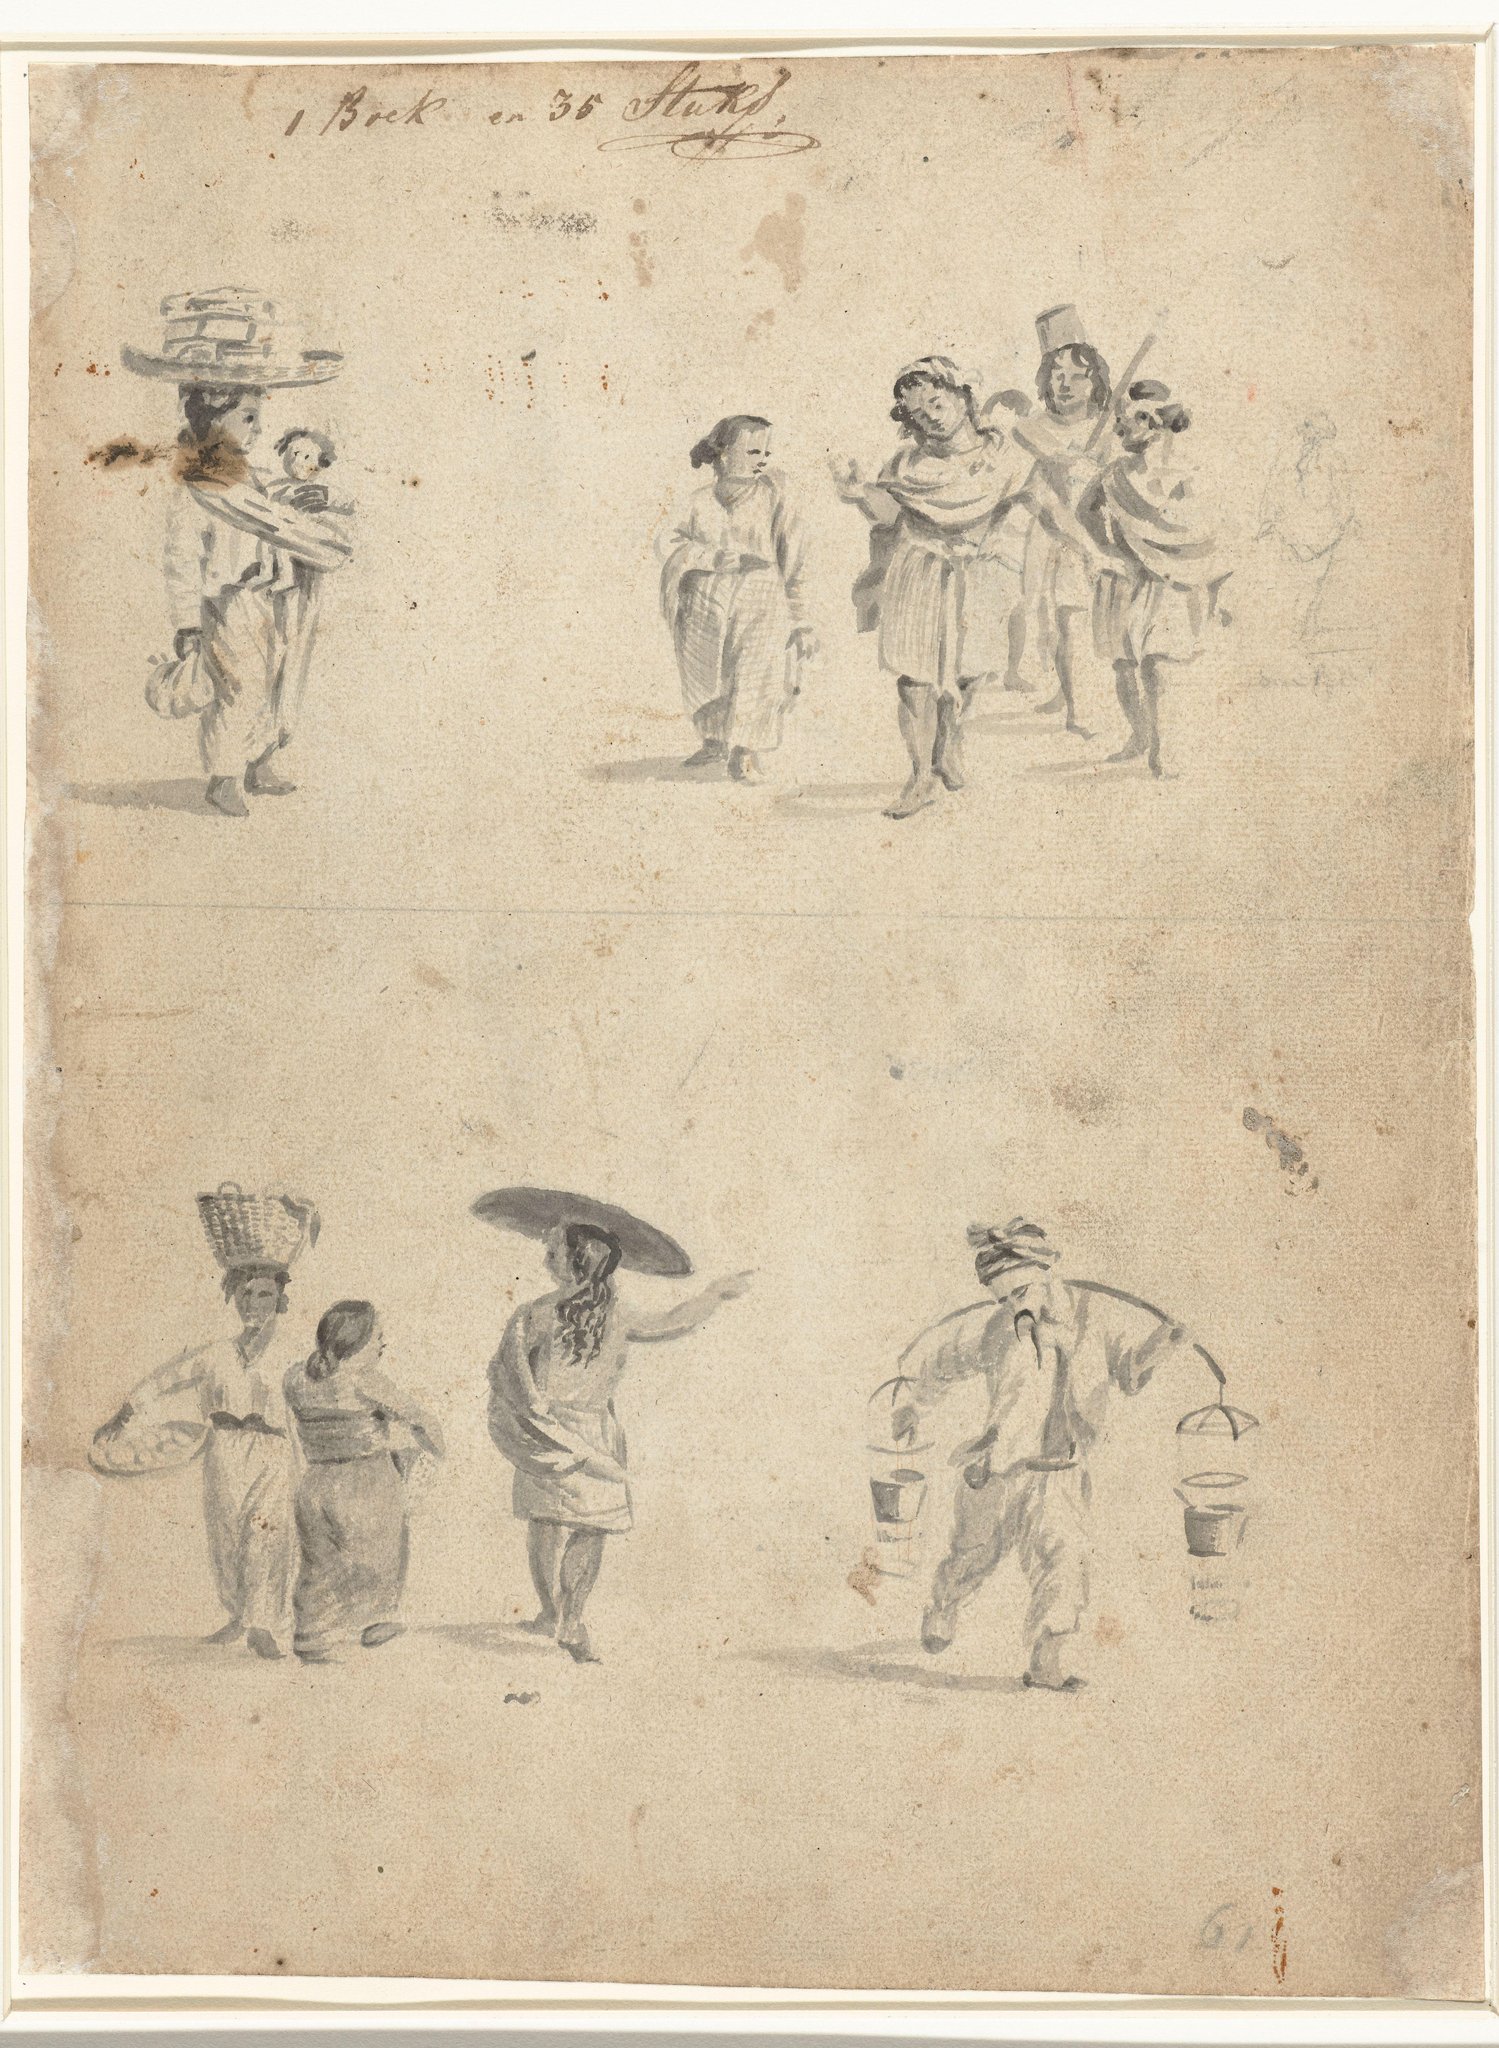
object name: drawing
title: Figuren van vrouwen in dagelijkse bezigheden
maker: wouter schouten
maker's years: 1638-1704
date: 1660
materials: paper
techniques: brush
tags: batavia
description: Figuren van vrouwen in dagelijkse bezigheden en een oude Chinees met een emmer.